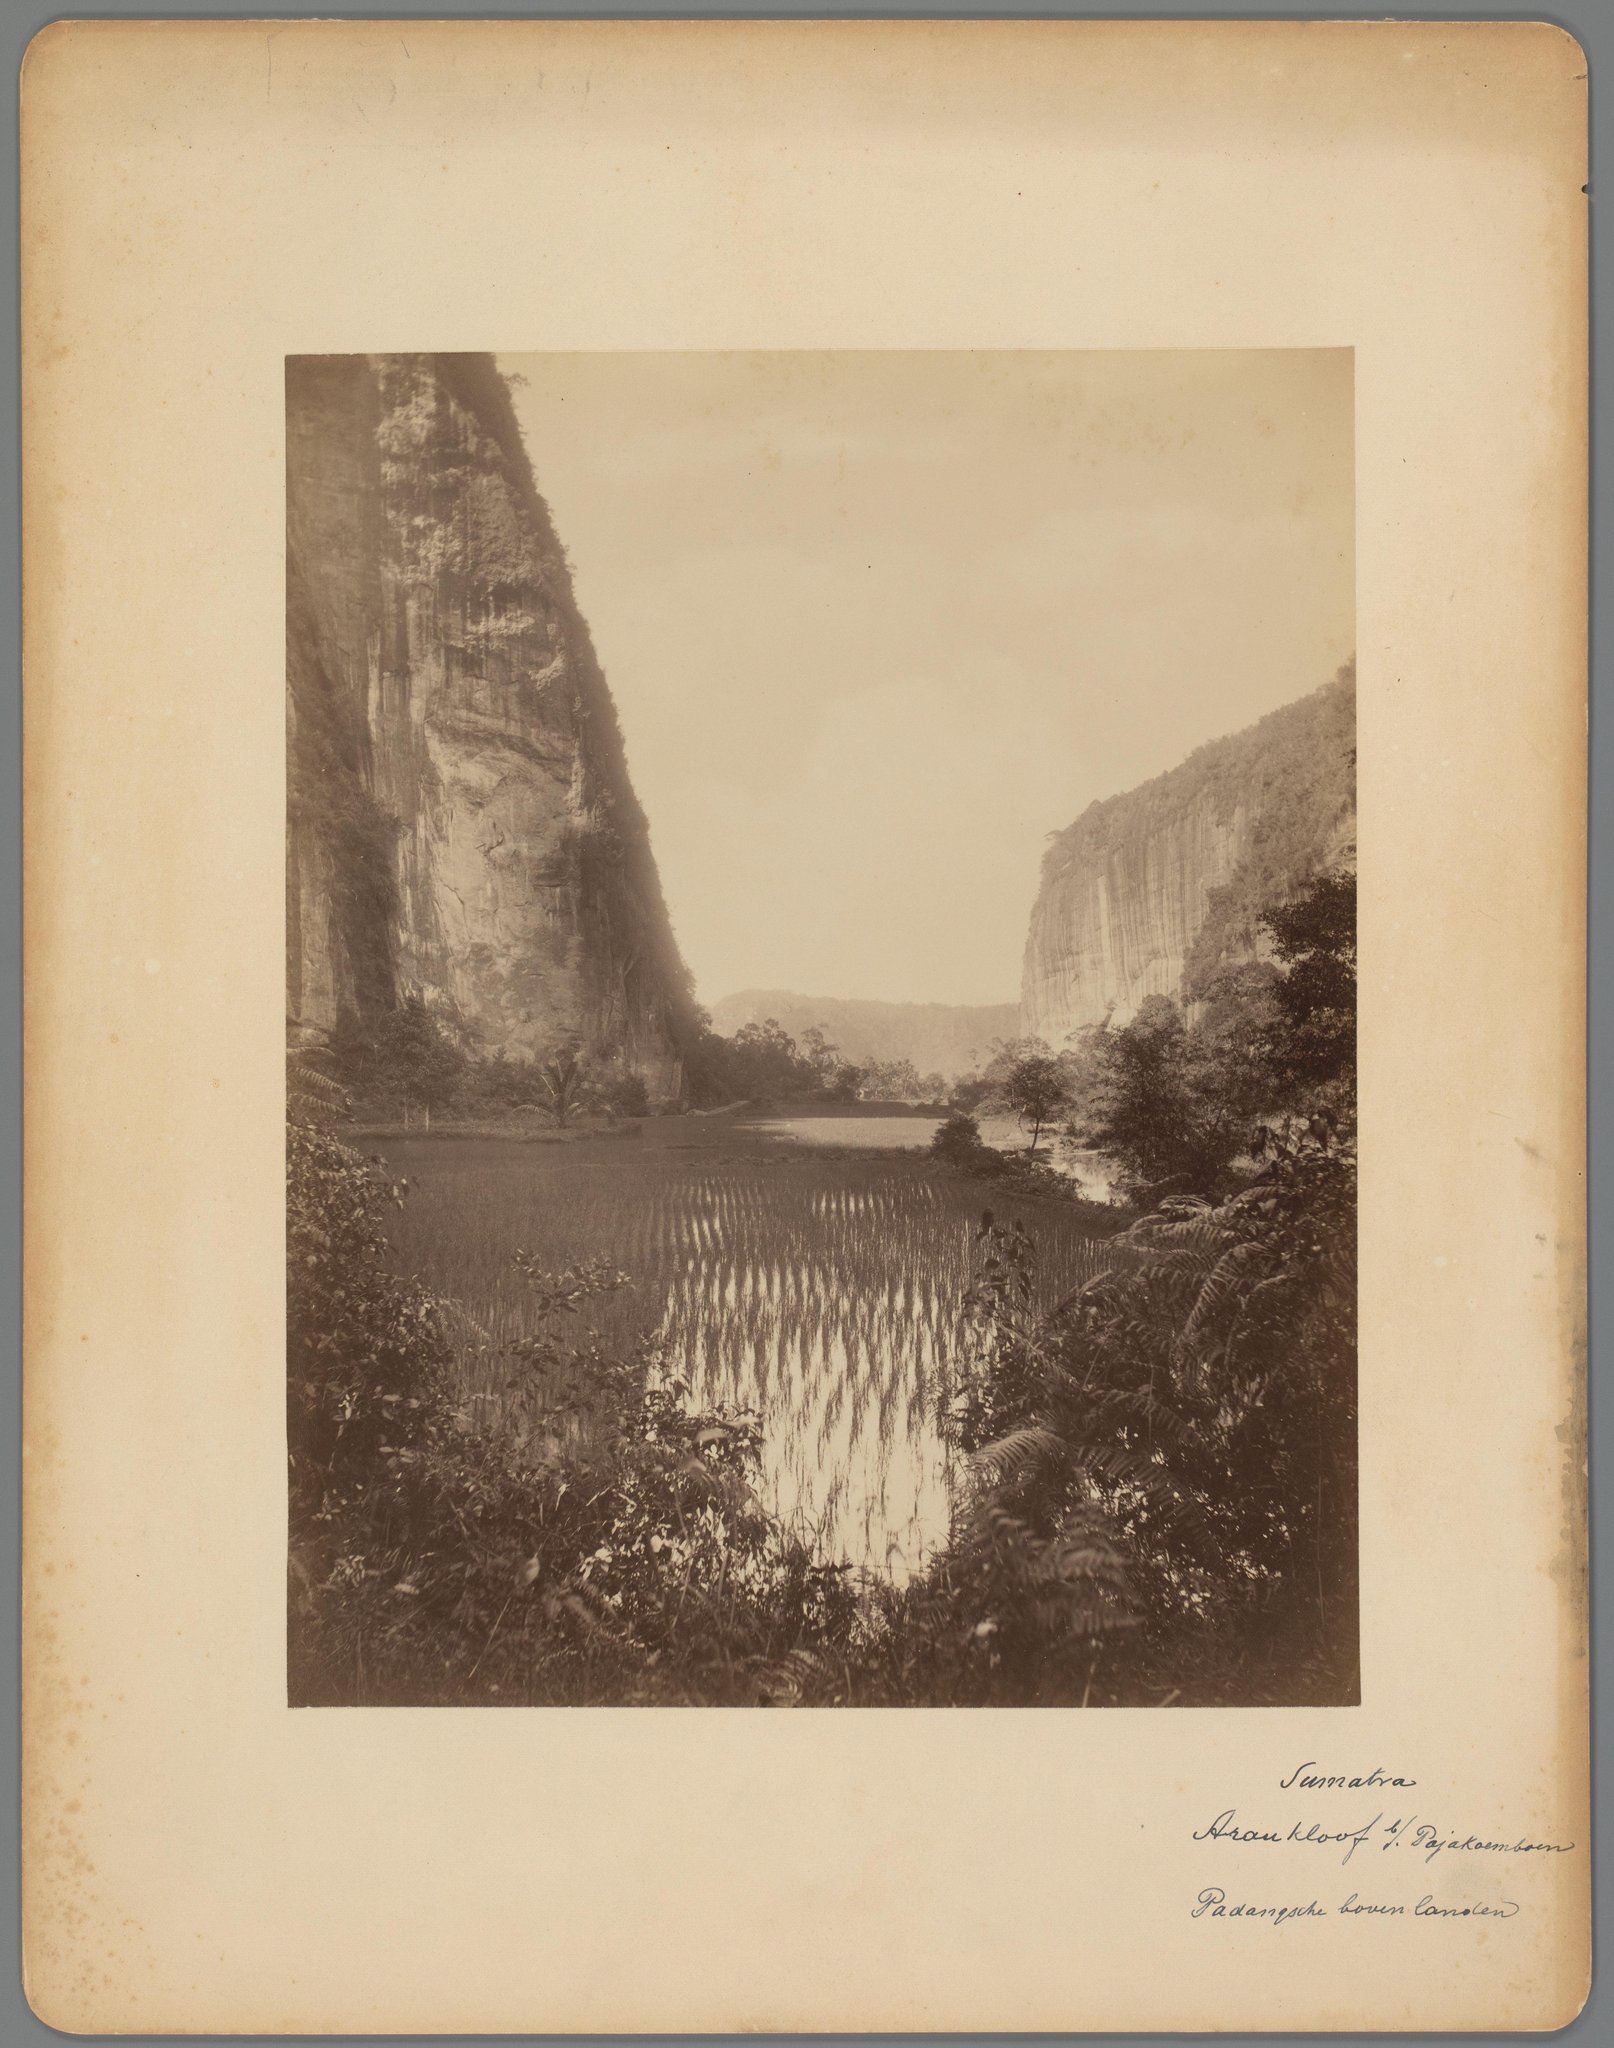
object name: photograph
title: Gezicht op de Arau-kloof, nabij Payakumbuh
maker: christiaan benjamin nieuwenhuis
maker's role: publisher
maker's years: 1863-1922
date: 1891-1895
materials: cardboard, paper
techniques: albumen print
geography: sumatera barat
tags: dale, valley, sawahs, rice paddies, sumatera barat (province)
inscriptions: inscription: ‘Foto’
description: Deze foto zat oorspronkelijk in prentenkabinet RP-F-AA3192.